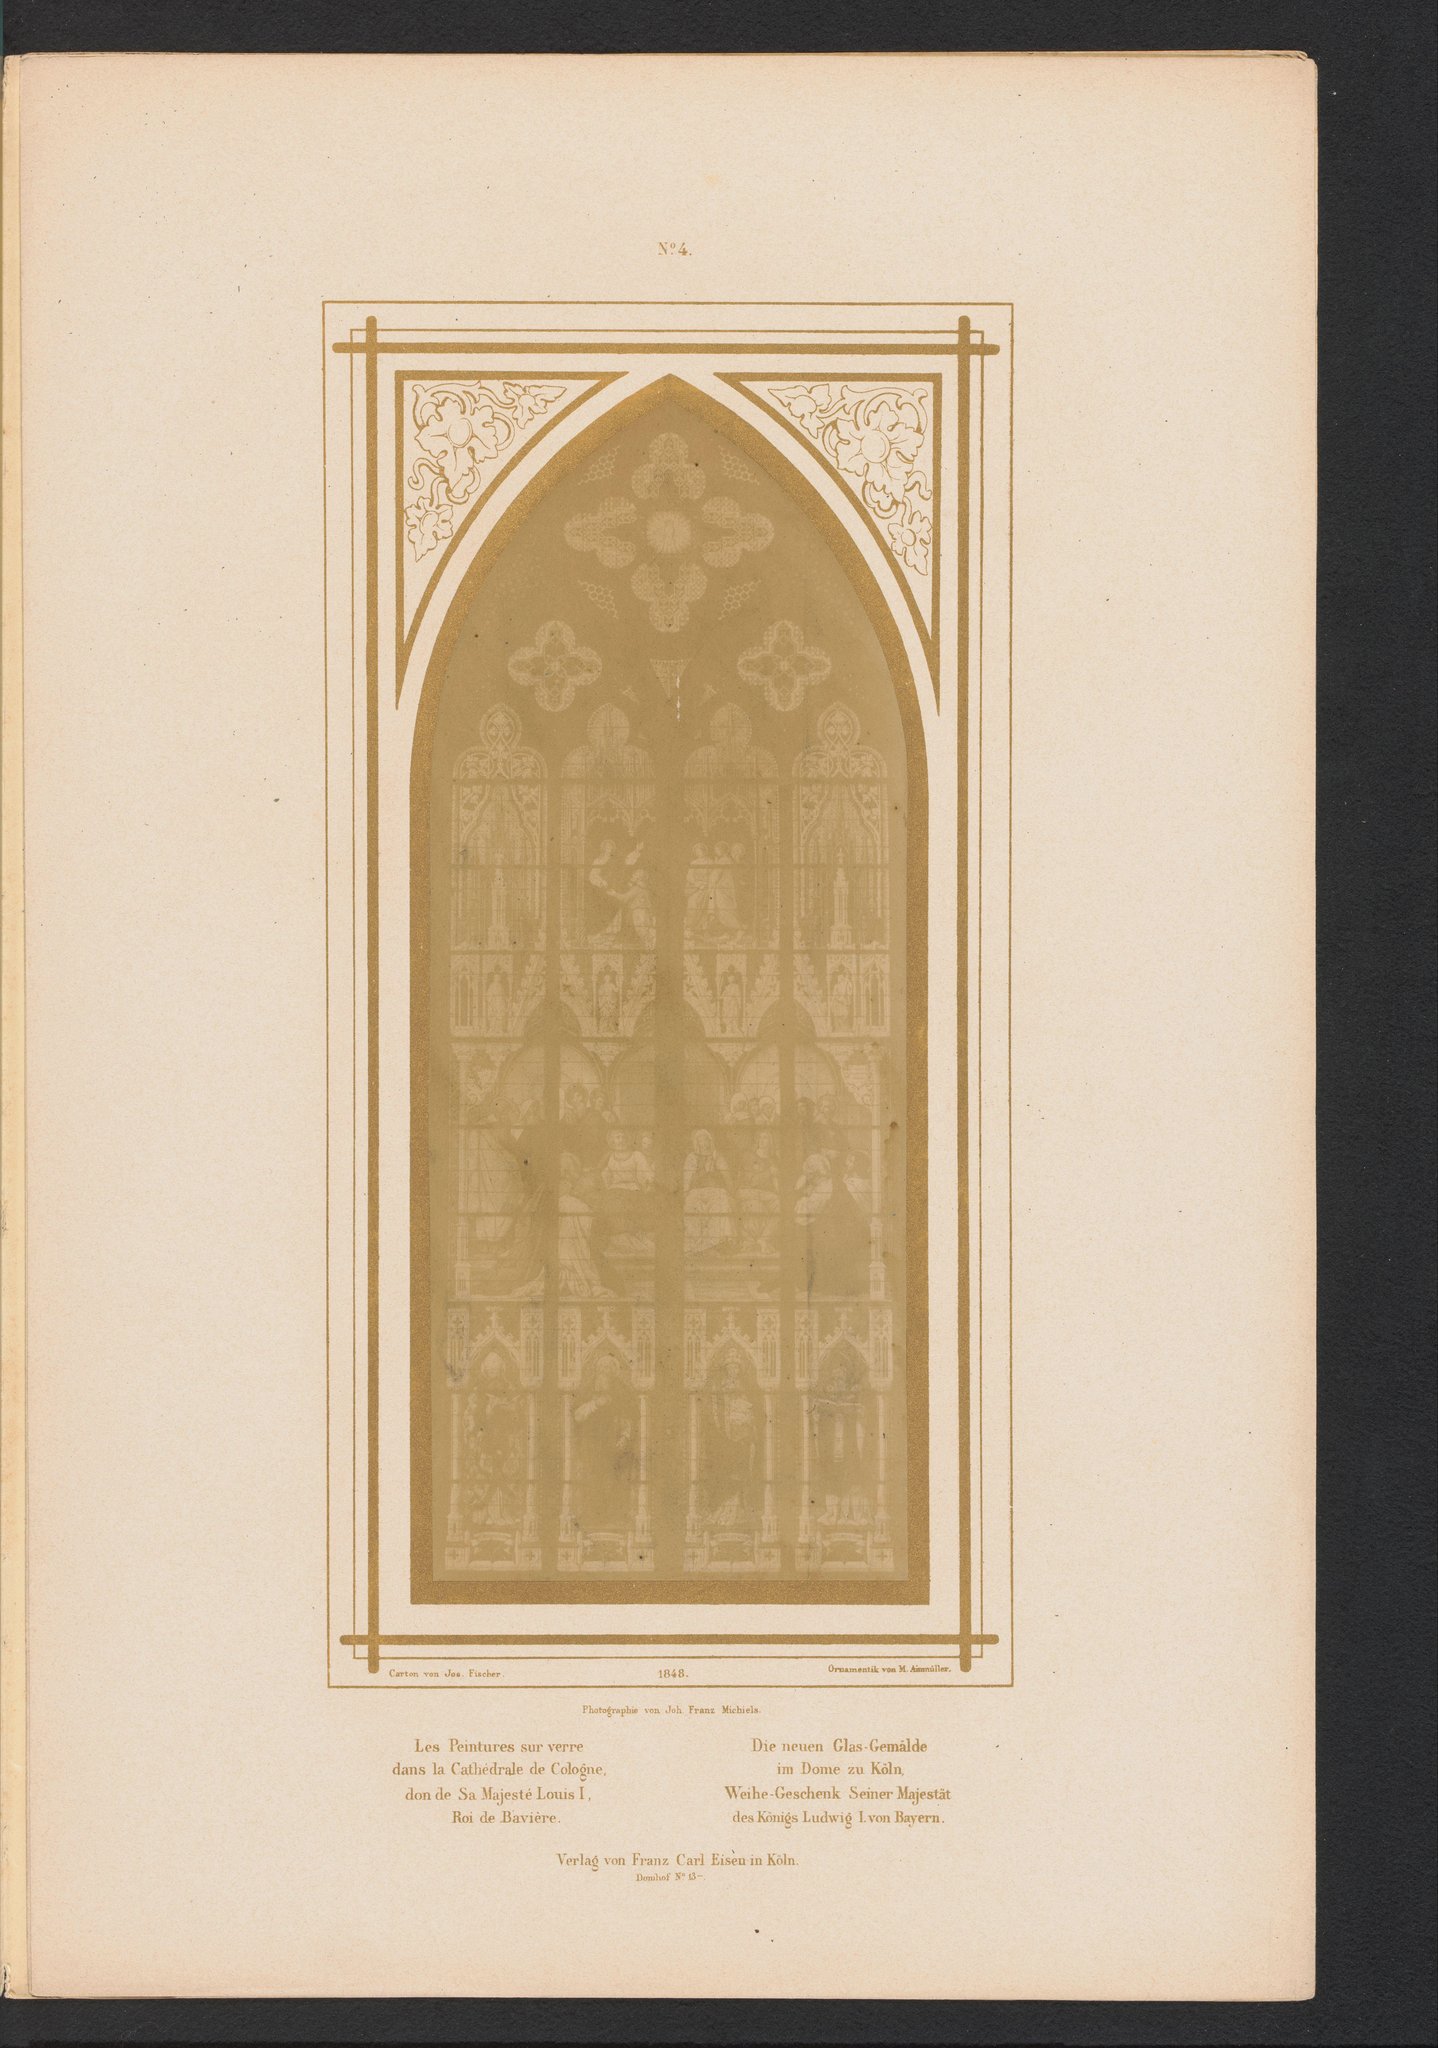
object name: page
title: Gebrandschilderd raam ontworpen door Max Emanuel Ainmiller, in de Dom van Keulen, Duitsland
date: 1849-1854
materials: photographic support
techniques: albumen print, lithograph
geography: cologne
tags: church-window, e.g. rose-window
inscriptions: date: ‘1848.’, inscription: ‘Carton von Jos. Fischer.’, number: ‘No 4.’, inscription: ‘Les Peintures sur verre/ dans la Cathédrale de Cologne,/ don de Sa Majesté Louis I,/ Roi de Bavière.’, inscription: ‘Ornamentik von M. Ainmüller.’, inscription: ‘Die neuen Glas-Gemälde/ im Dome zu Köln,/ Weihe-Geschenk Seiner Majestät/ des Königs Ludwig I von Bayern.’, address: ‘Domhof No 13-.’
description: Deze foto maakt deel uit van een omslag met vijf foto's en één tekstblad.